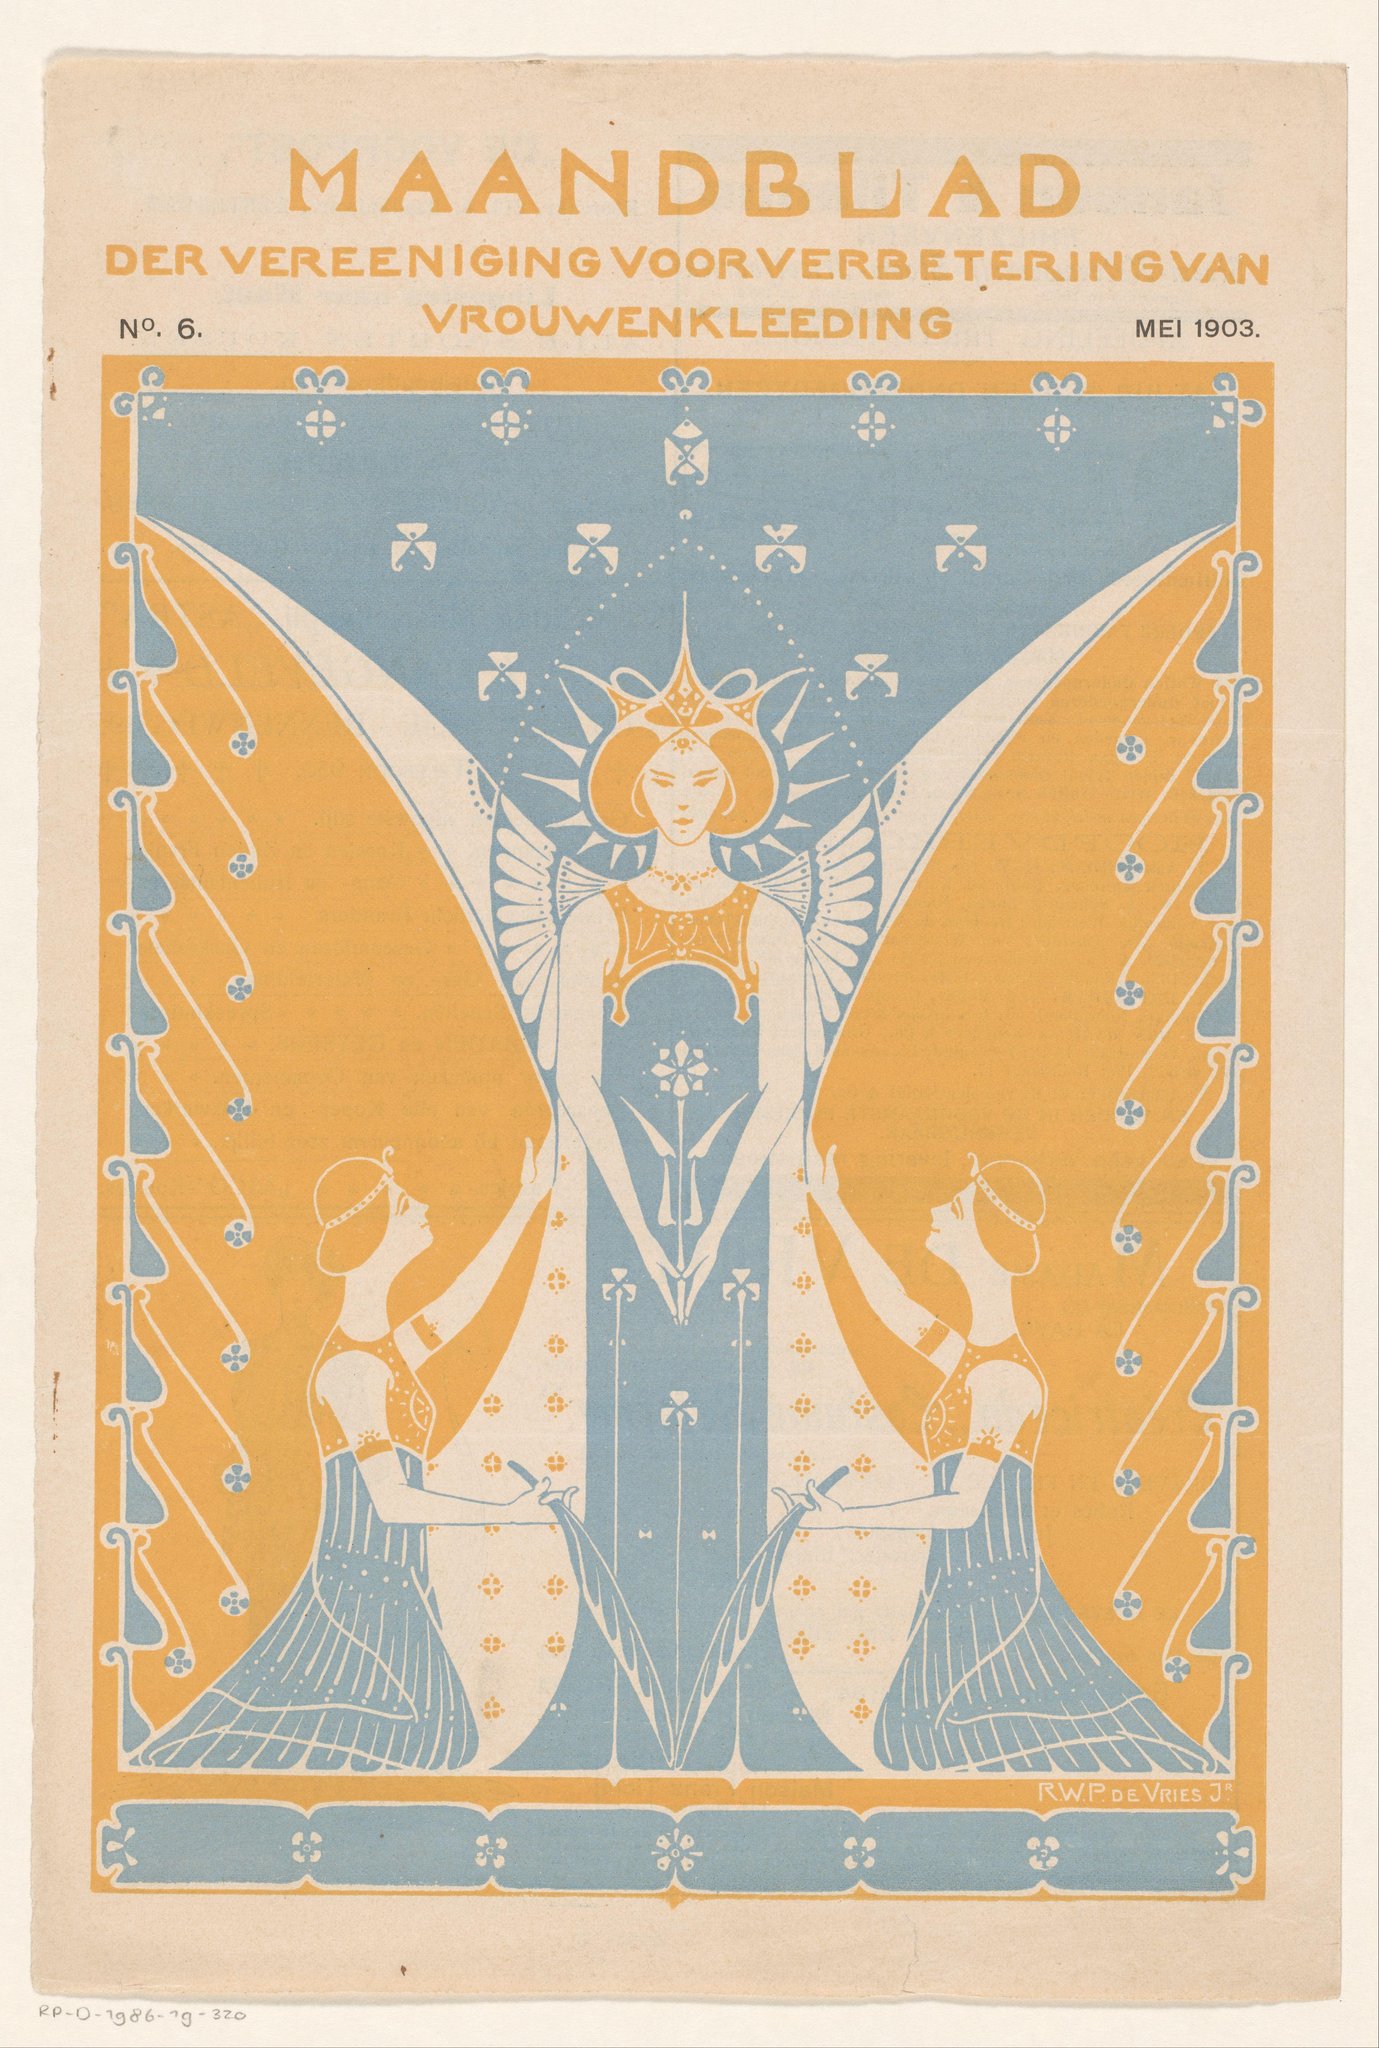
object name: wrapper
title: Omslag van: Maandblad der Vereeniging voor verbetering van vrouwenkleeding, No. 6, mei 1903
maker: reinier willem petrus de vries (1874-1953)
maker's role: draughtsman, print maker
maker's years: 1874-1953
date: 1903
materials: paper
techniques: lithograph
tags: ornaments ~ art, dress, gown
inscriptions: collector's mark: ‘R:MVS.’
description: Staande vrouw in een versierde jurk met de handen voor haar lichaam gevouwen. Naast haar knielen twee vrouwen met palmtakken.